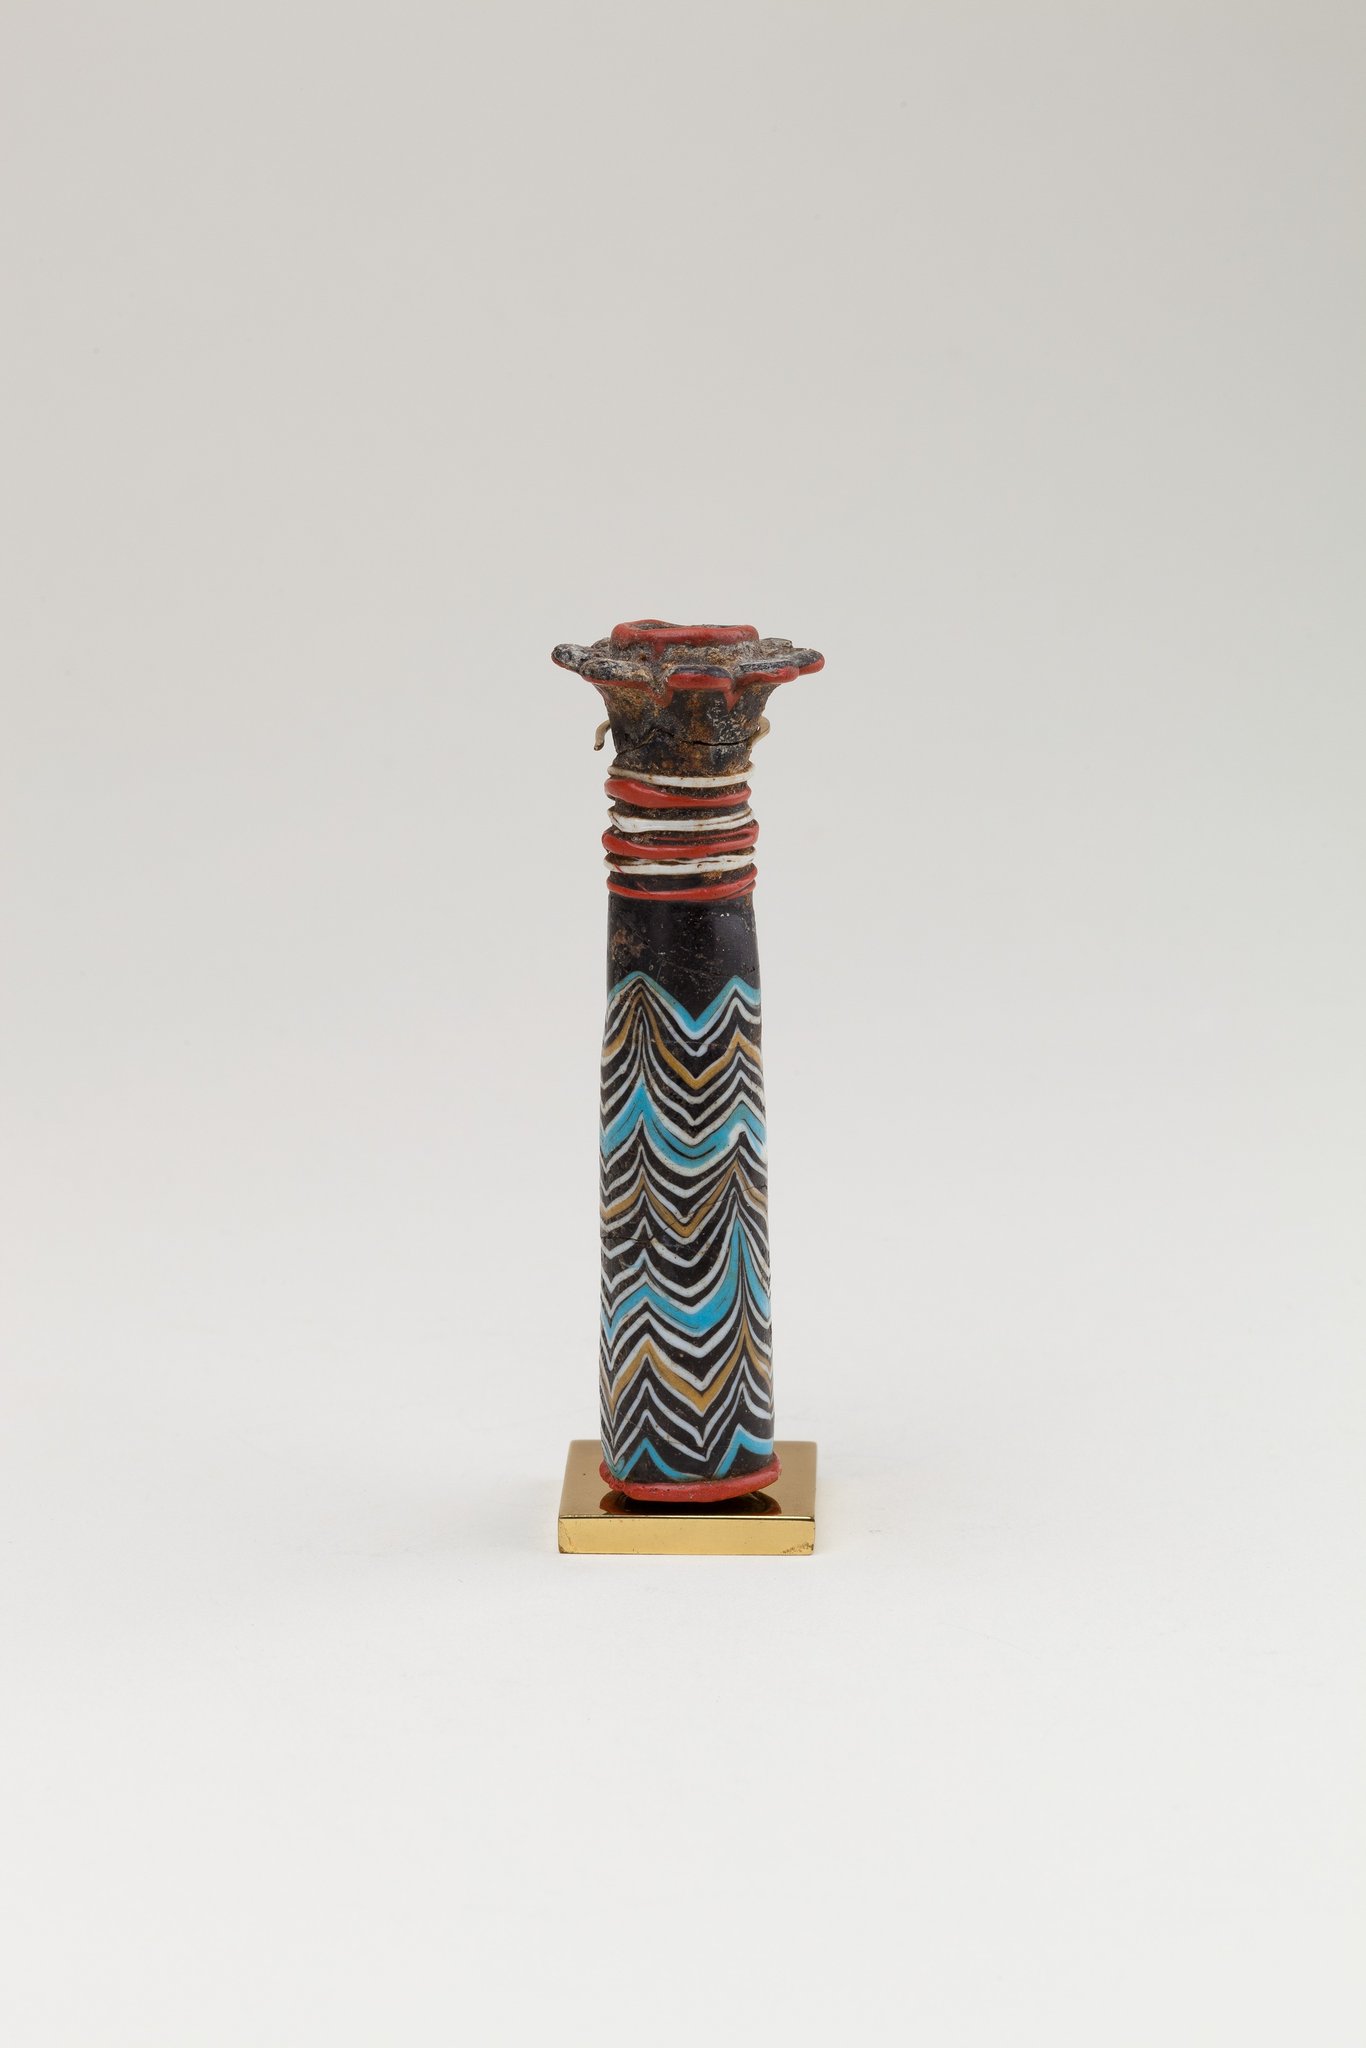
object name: kohl tube, palm column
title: Kohl Tube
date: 1295-1070 BCE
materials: glass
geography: egypt